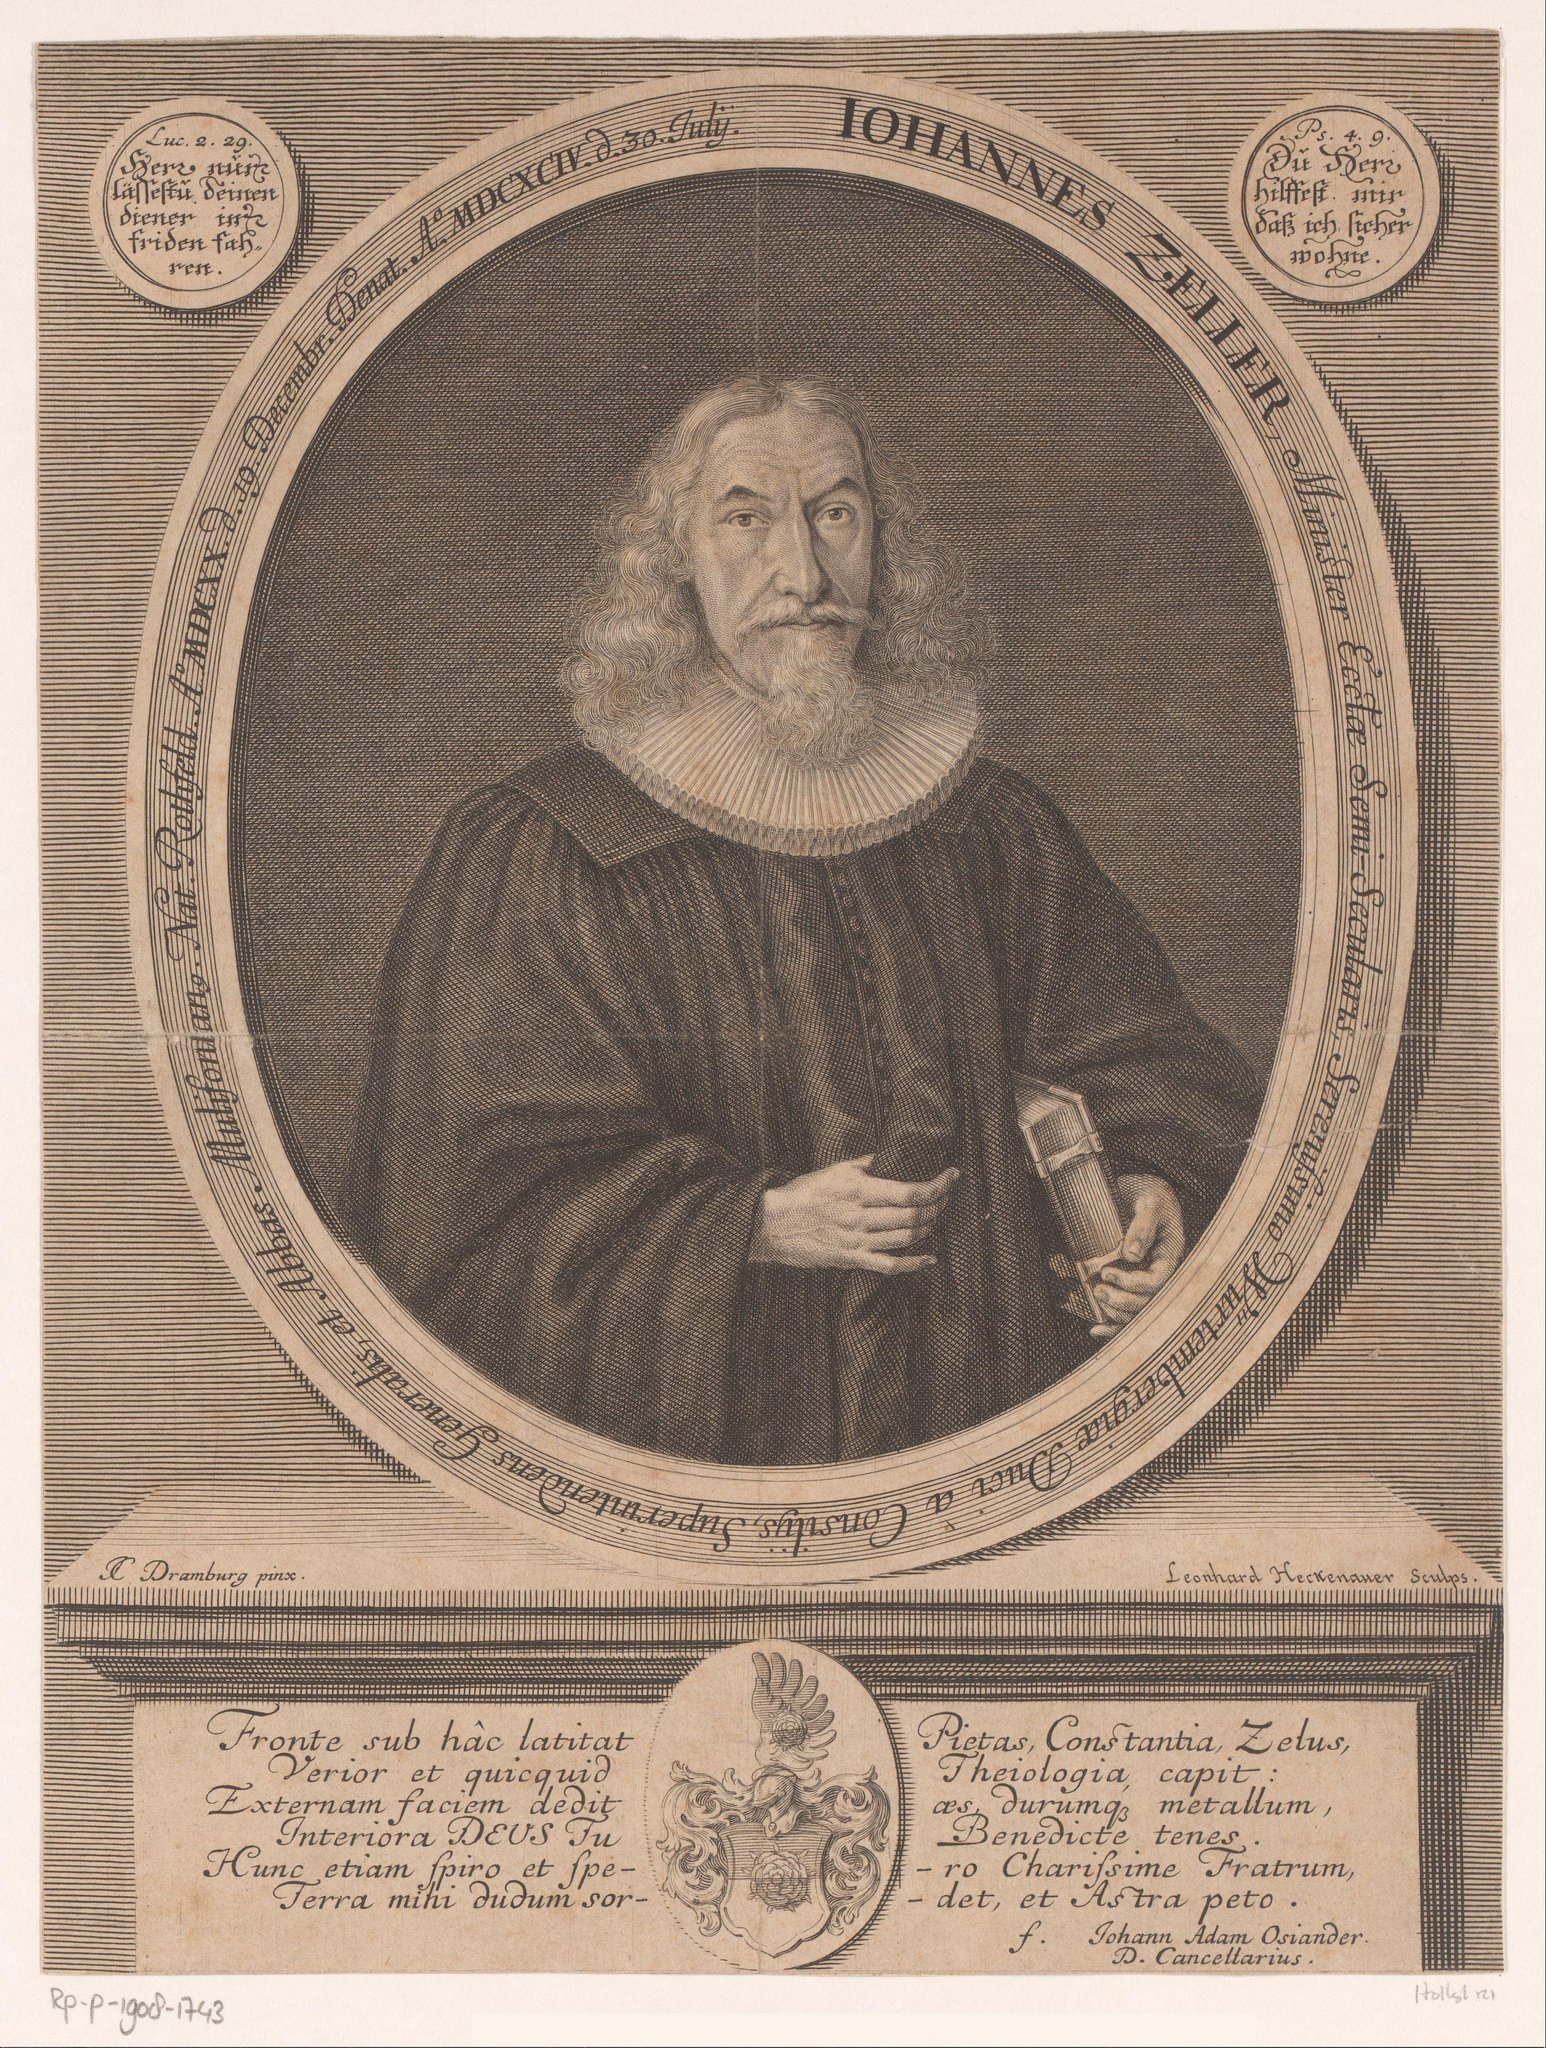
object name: print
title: Portret van Johann Zeller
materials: paper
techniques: engraving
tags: historical persons, book, armorial bearing, heraldry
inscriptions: collector's mark: Lugt 2228